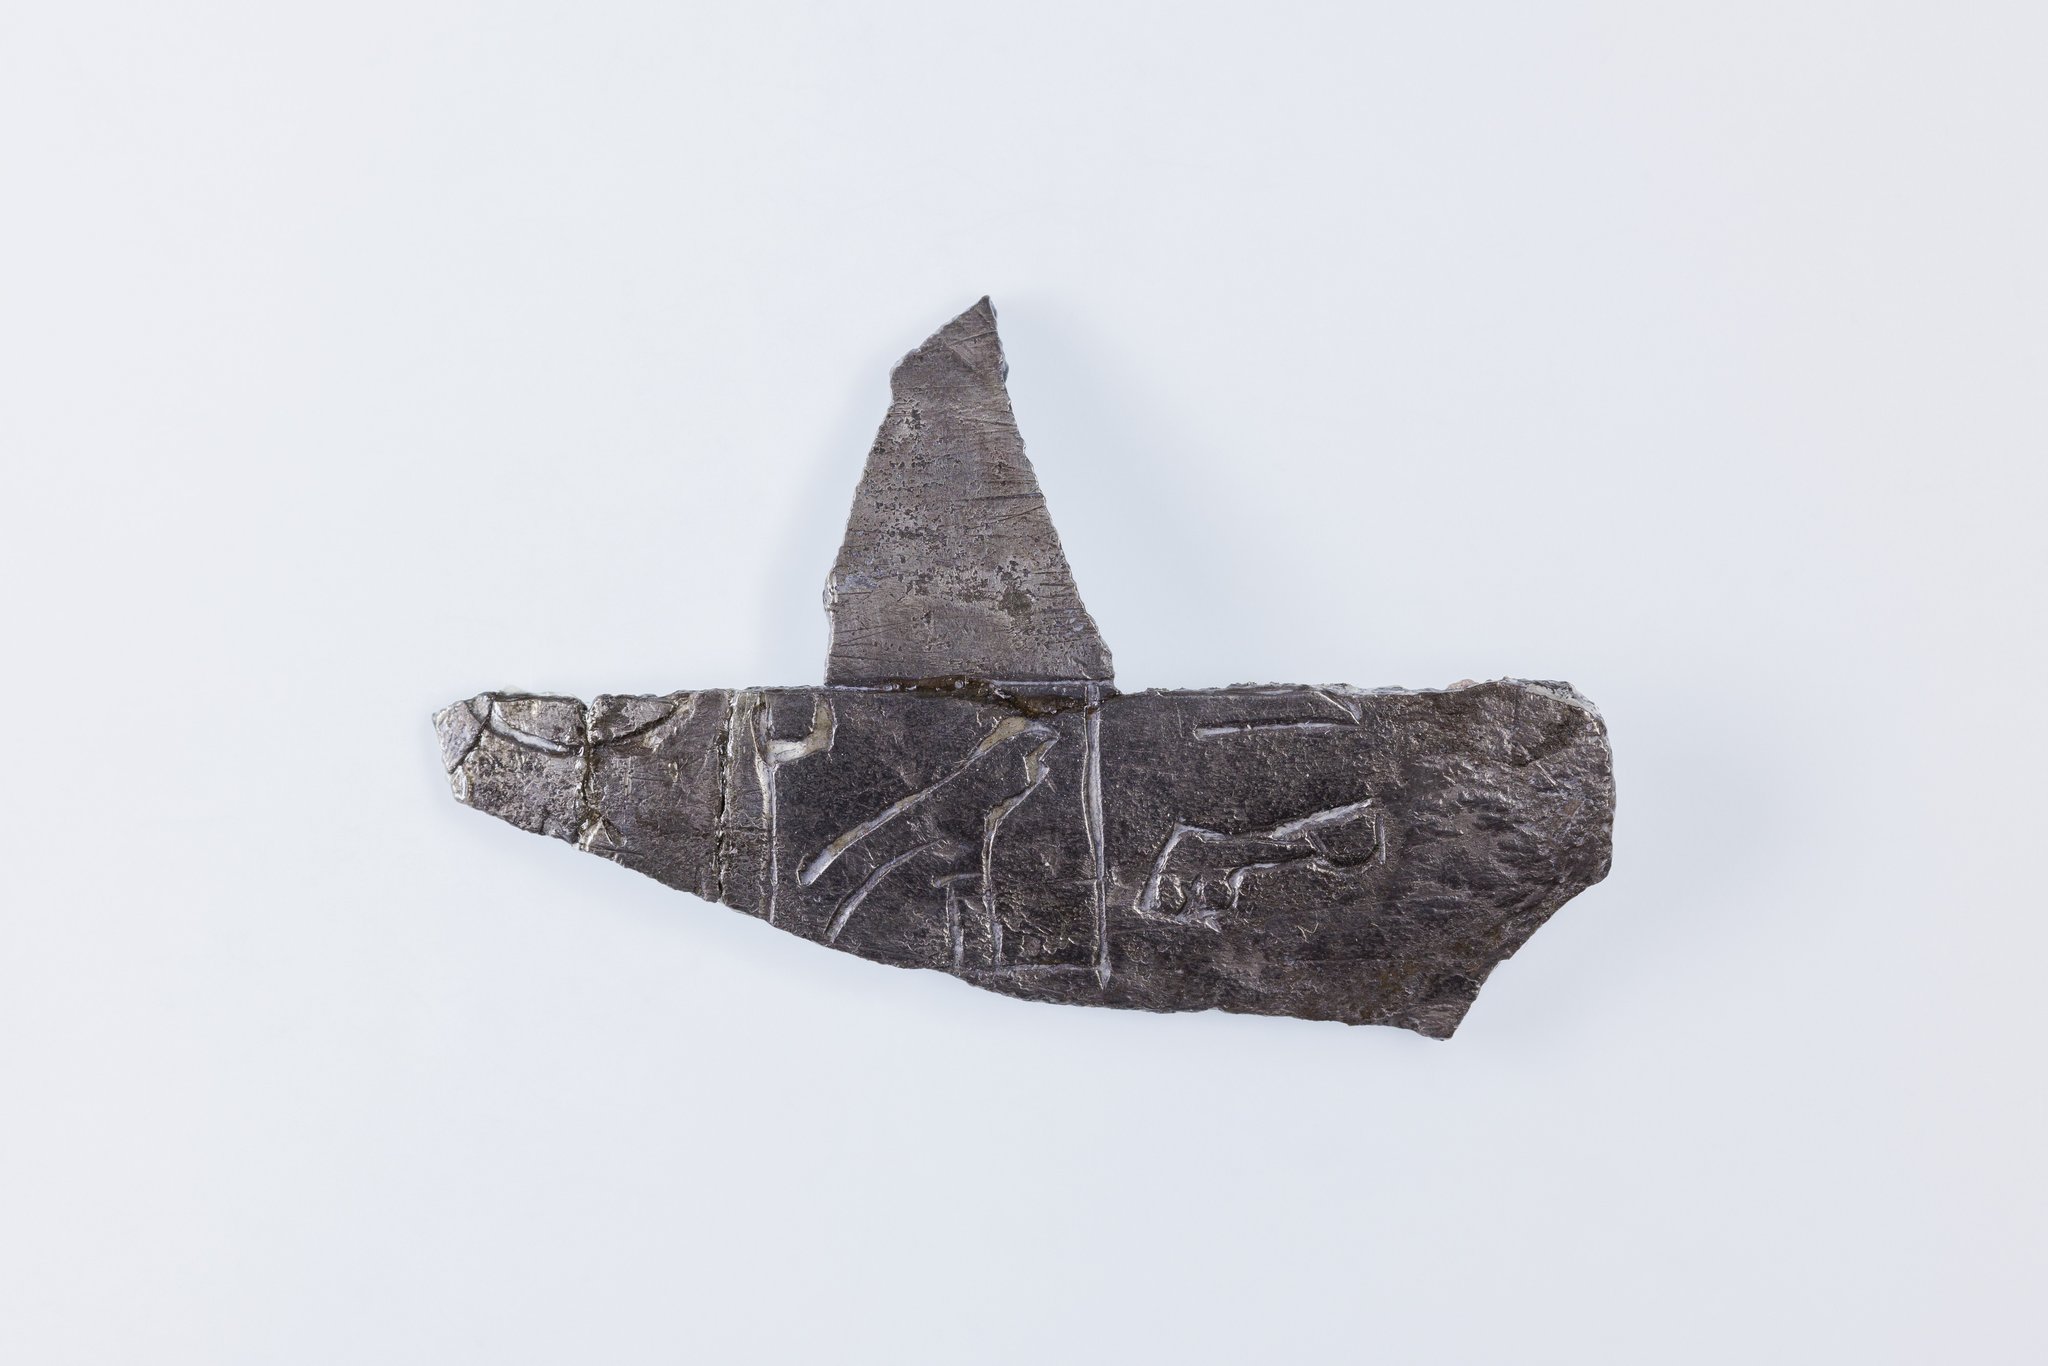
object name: vessel fragment, tell basta treasure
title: Vessel fragment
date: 1070-712 BCE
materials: silver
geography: egypt